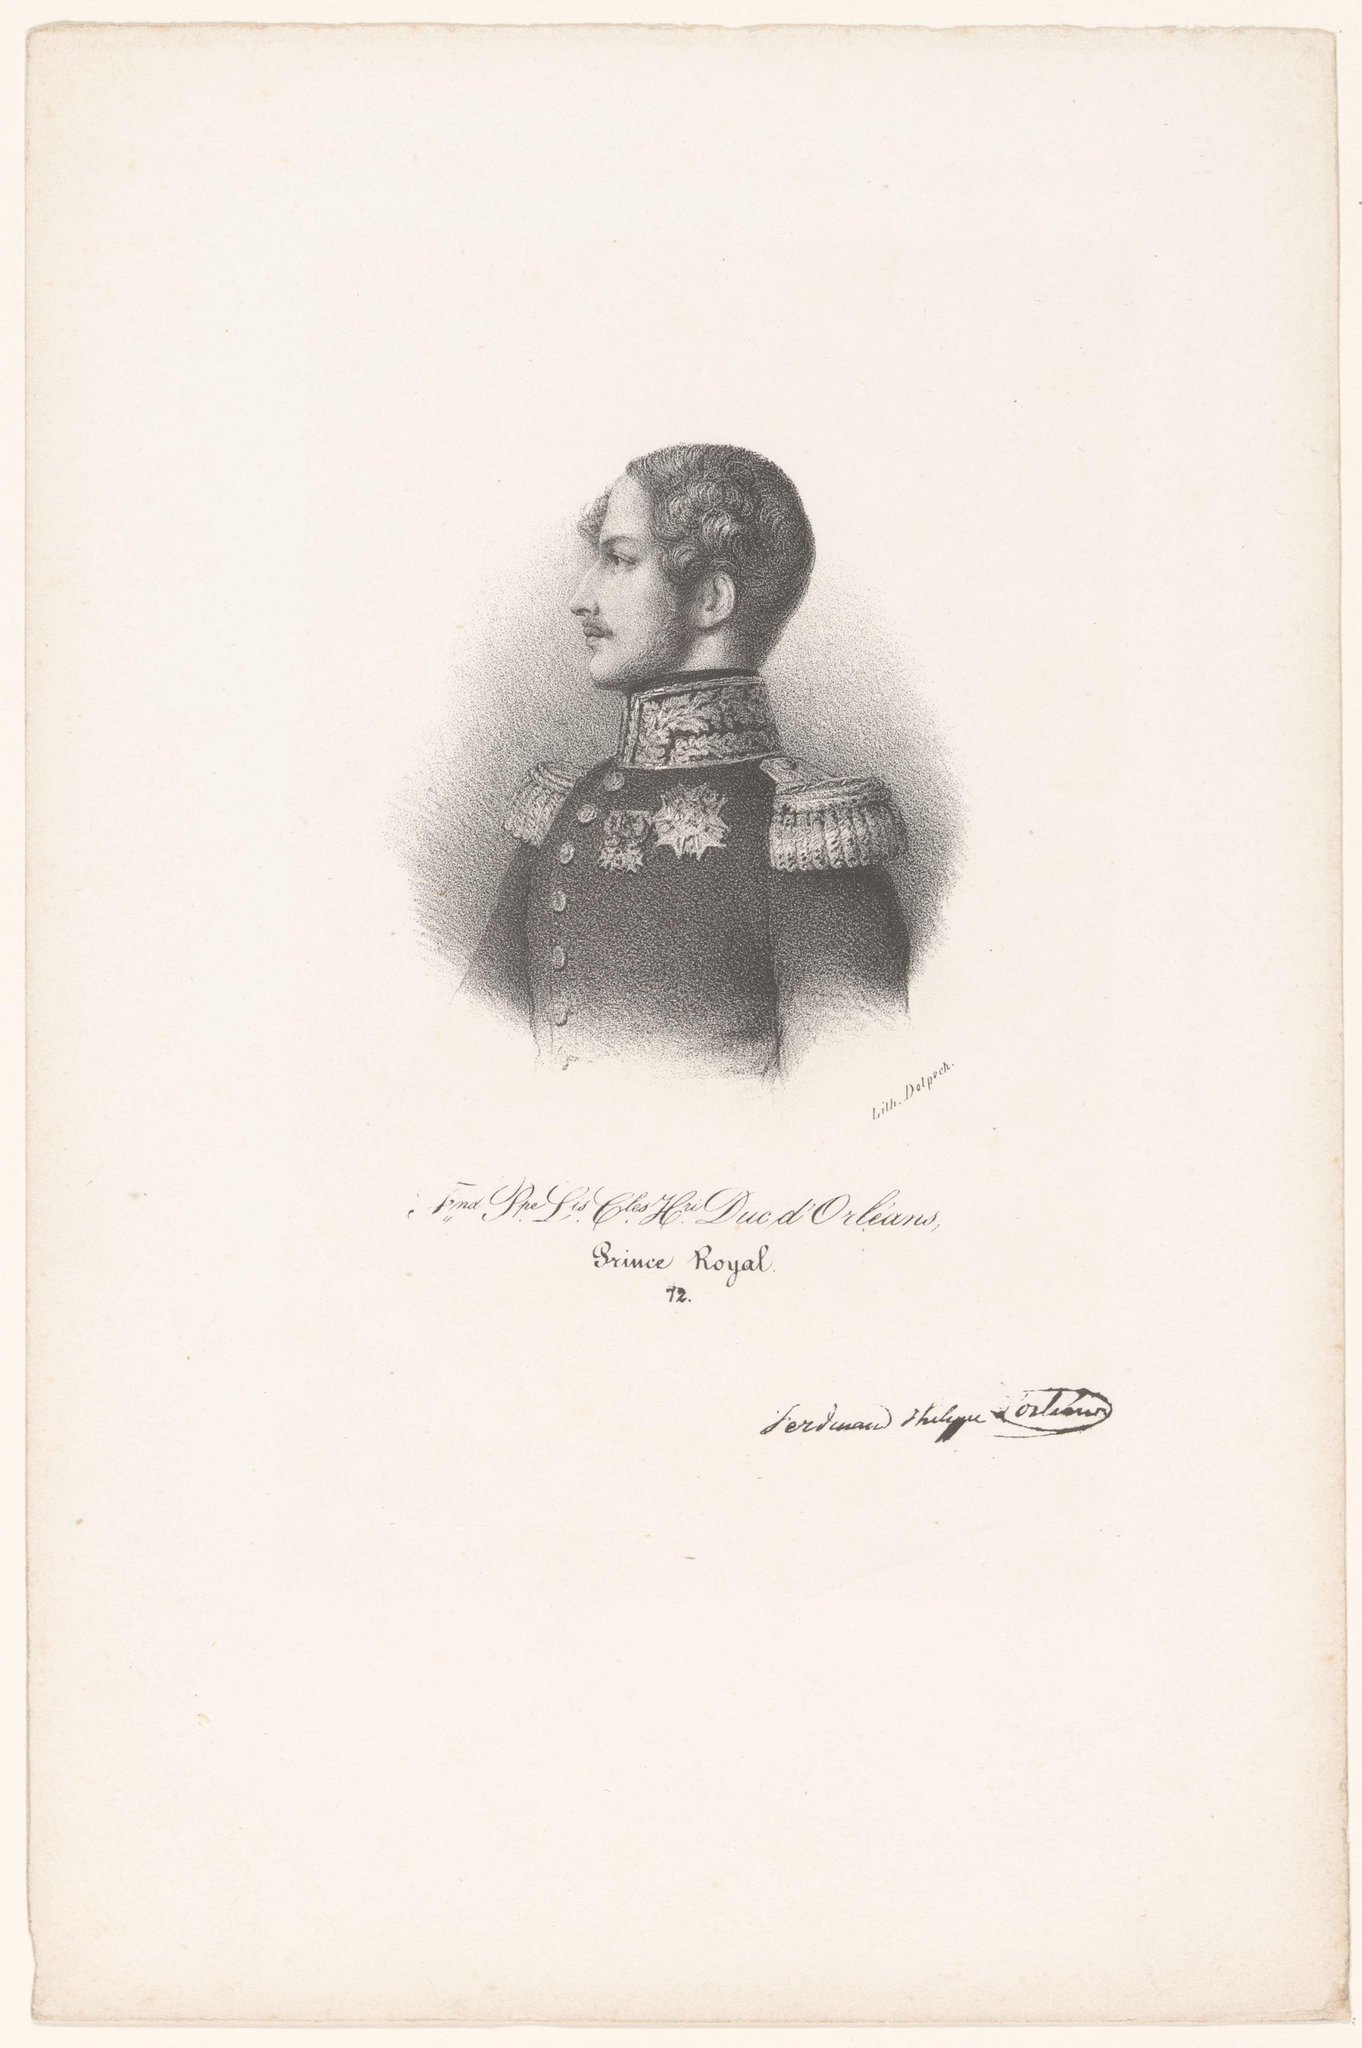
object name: print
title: Portret van Ferdinand-Philippe d'Orléans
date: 1818-1842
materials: paper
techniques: lithograph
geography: paris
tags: historical persons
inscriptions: collector's mark: Lugt 2228a